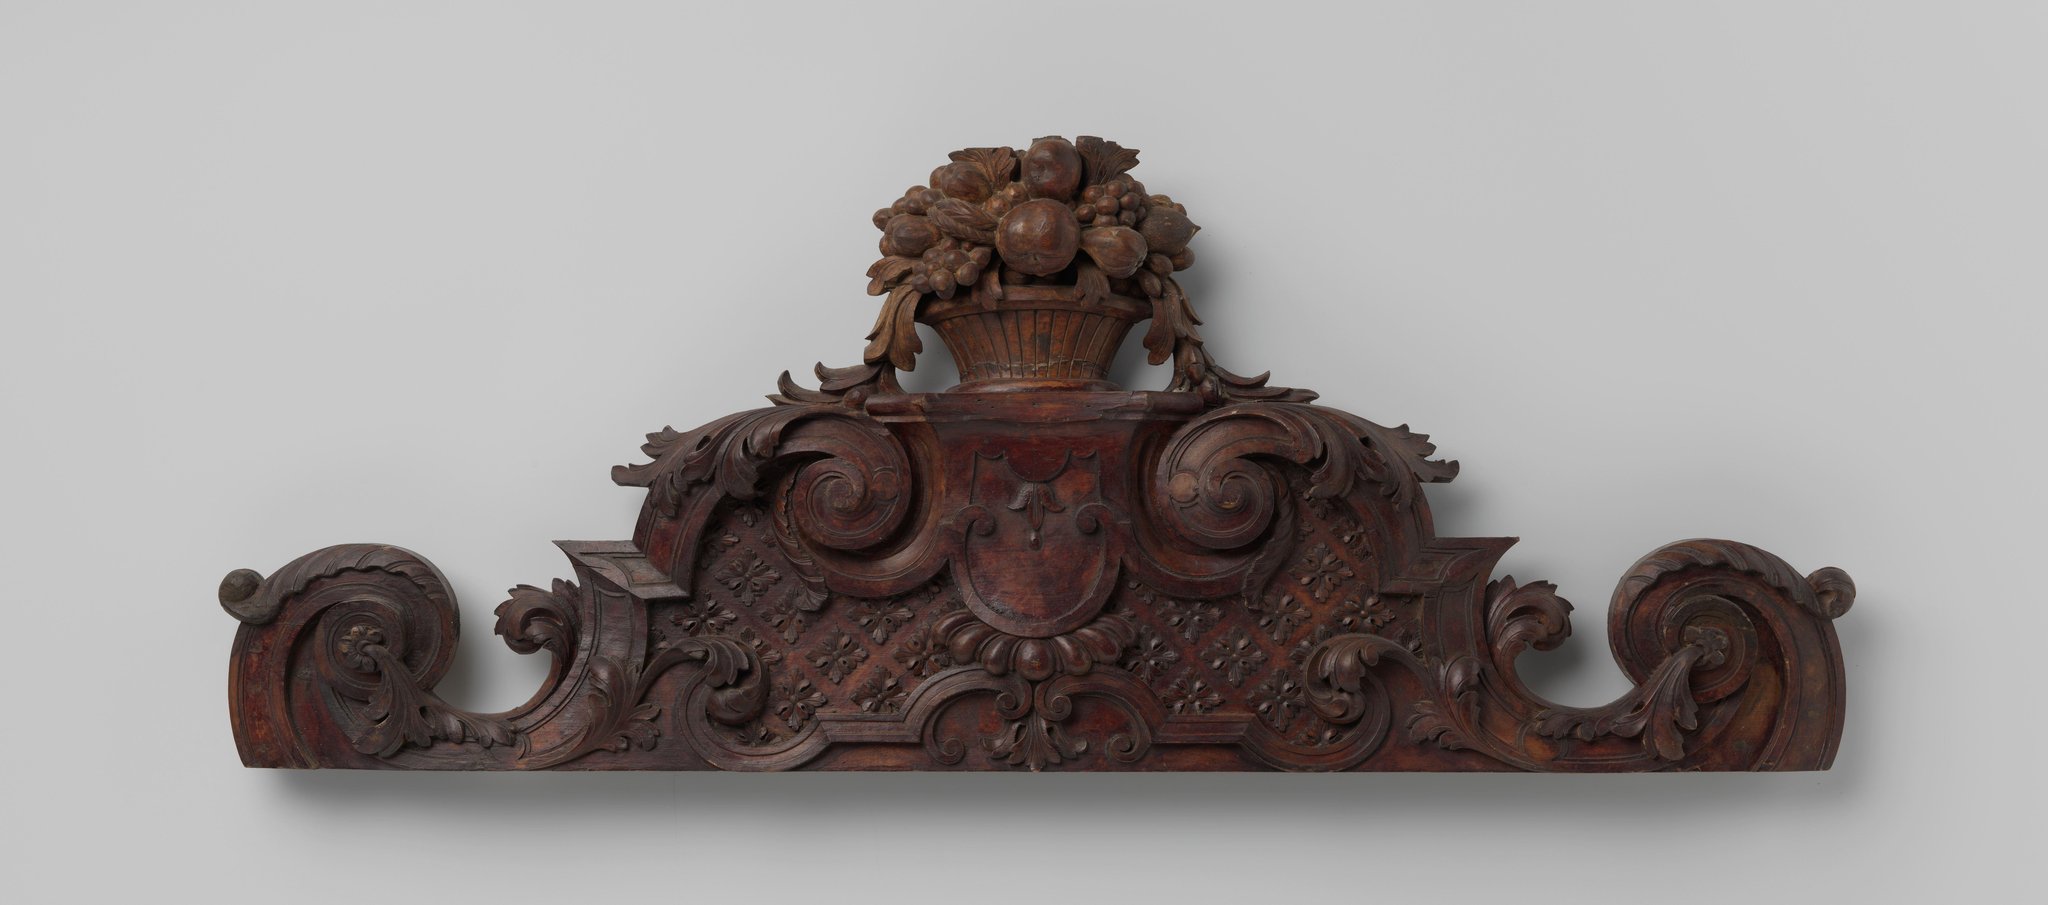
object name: transom window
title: Bekroning of bovenlicht van grenenhout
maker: Anonymous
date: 1700-1715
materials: wood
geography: netherlands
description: Bekroning van grenenhout, bestaande uit geknakte voluten, welke een jeu-de-fond met lambrequin omlijsten, bekroond door een korf met vruchten, waaruit acanthusguirlanden voortkomen. Diverse delen zijn met was aangevuld; voor de korf schijnt een stuk te ontbreken.